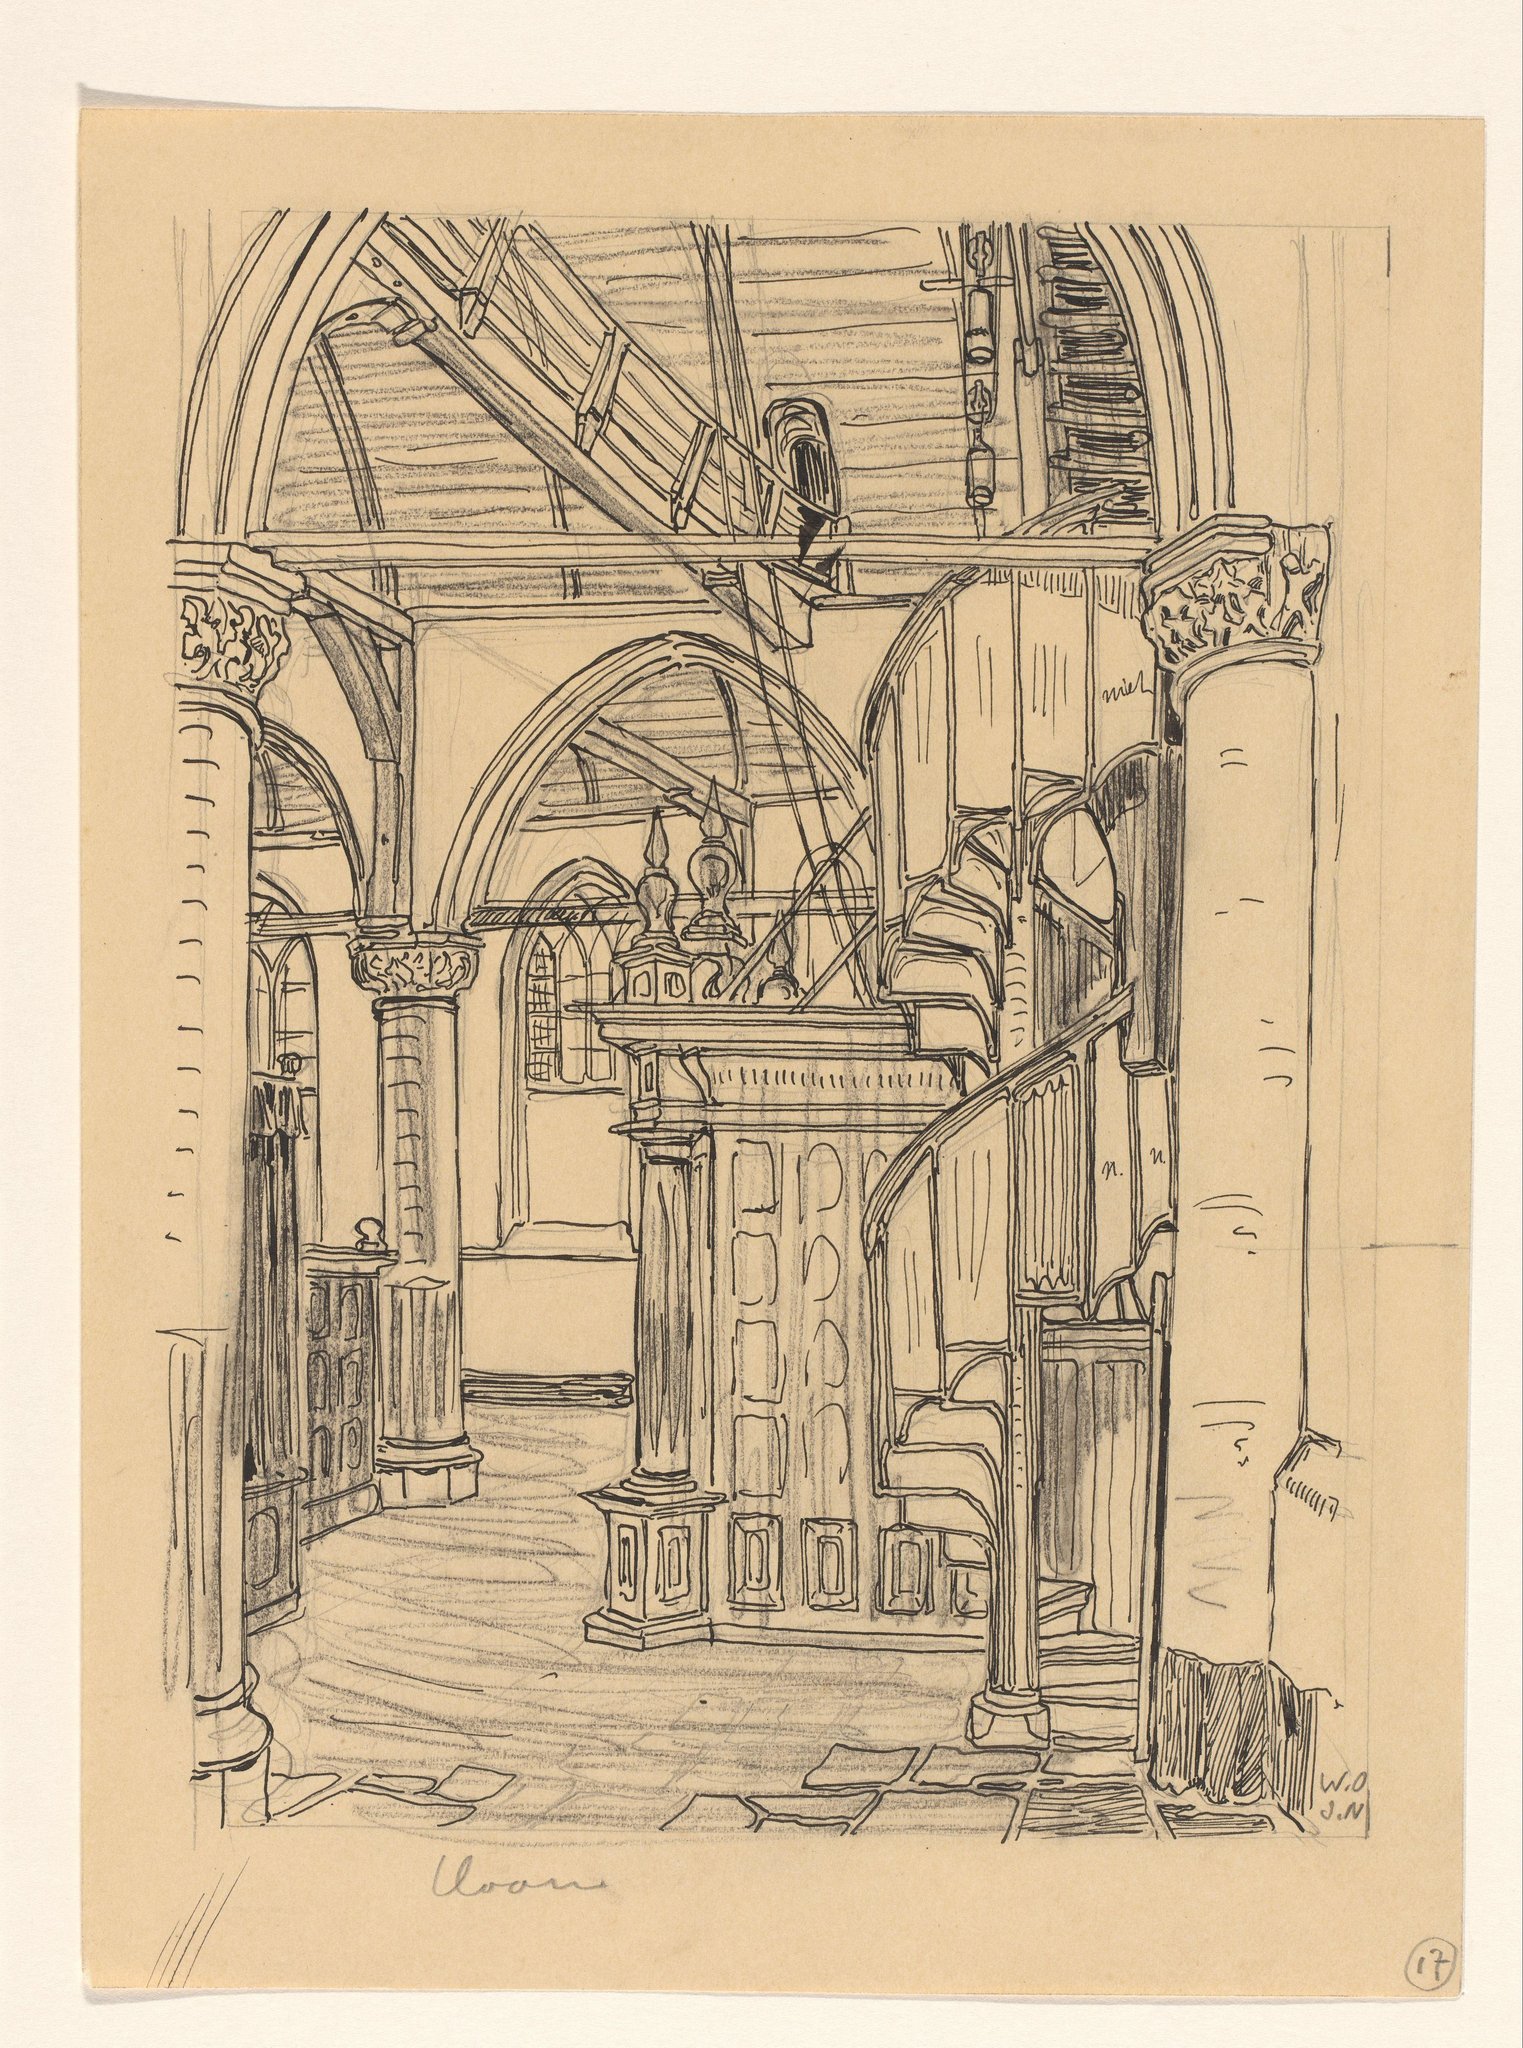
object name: boekillustratie ontwerp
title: Interieur van de Noorderkerk te Hoorn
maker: wijnand otto jan nieuwenkamp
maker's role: draughtsman, print maker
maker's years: 1874-1950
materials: chalk, ink, paper, pencil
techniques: pen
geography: hoorn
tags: interior of church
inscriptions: inscription: ‘Hoorn’, number: ‘17’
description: Ontwerp voor een boekillustratie voor: Nieuwenkamp, W.O.J. en Veldheer, J.G. Oude Hollandsche steden aan de Zuiderzee. Haarlem: De Erven F. Bohn, 1897. De Noorderkerk is gewijd aan Maria en wordt daarom ook wel Mariakerk genoemd. Ook in de publicatie wordt verwezen naar de 'St.-Mariakerk'. De tekening is niet opgenomen in de publicatie.